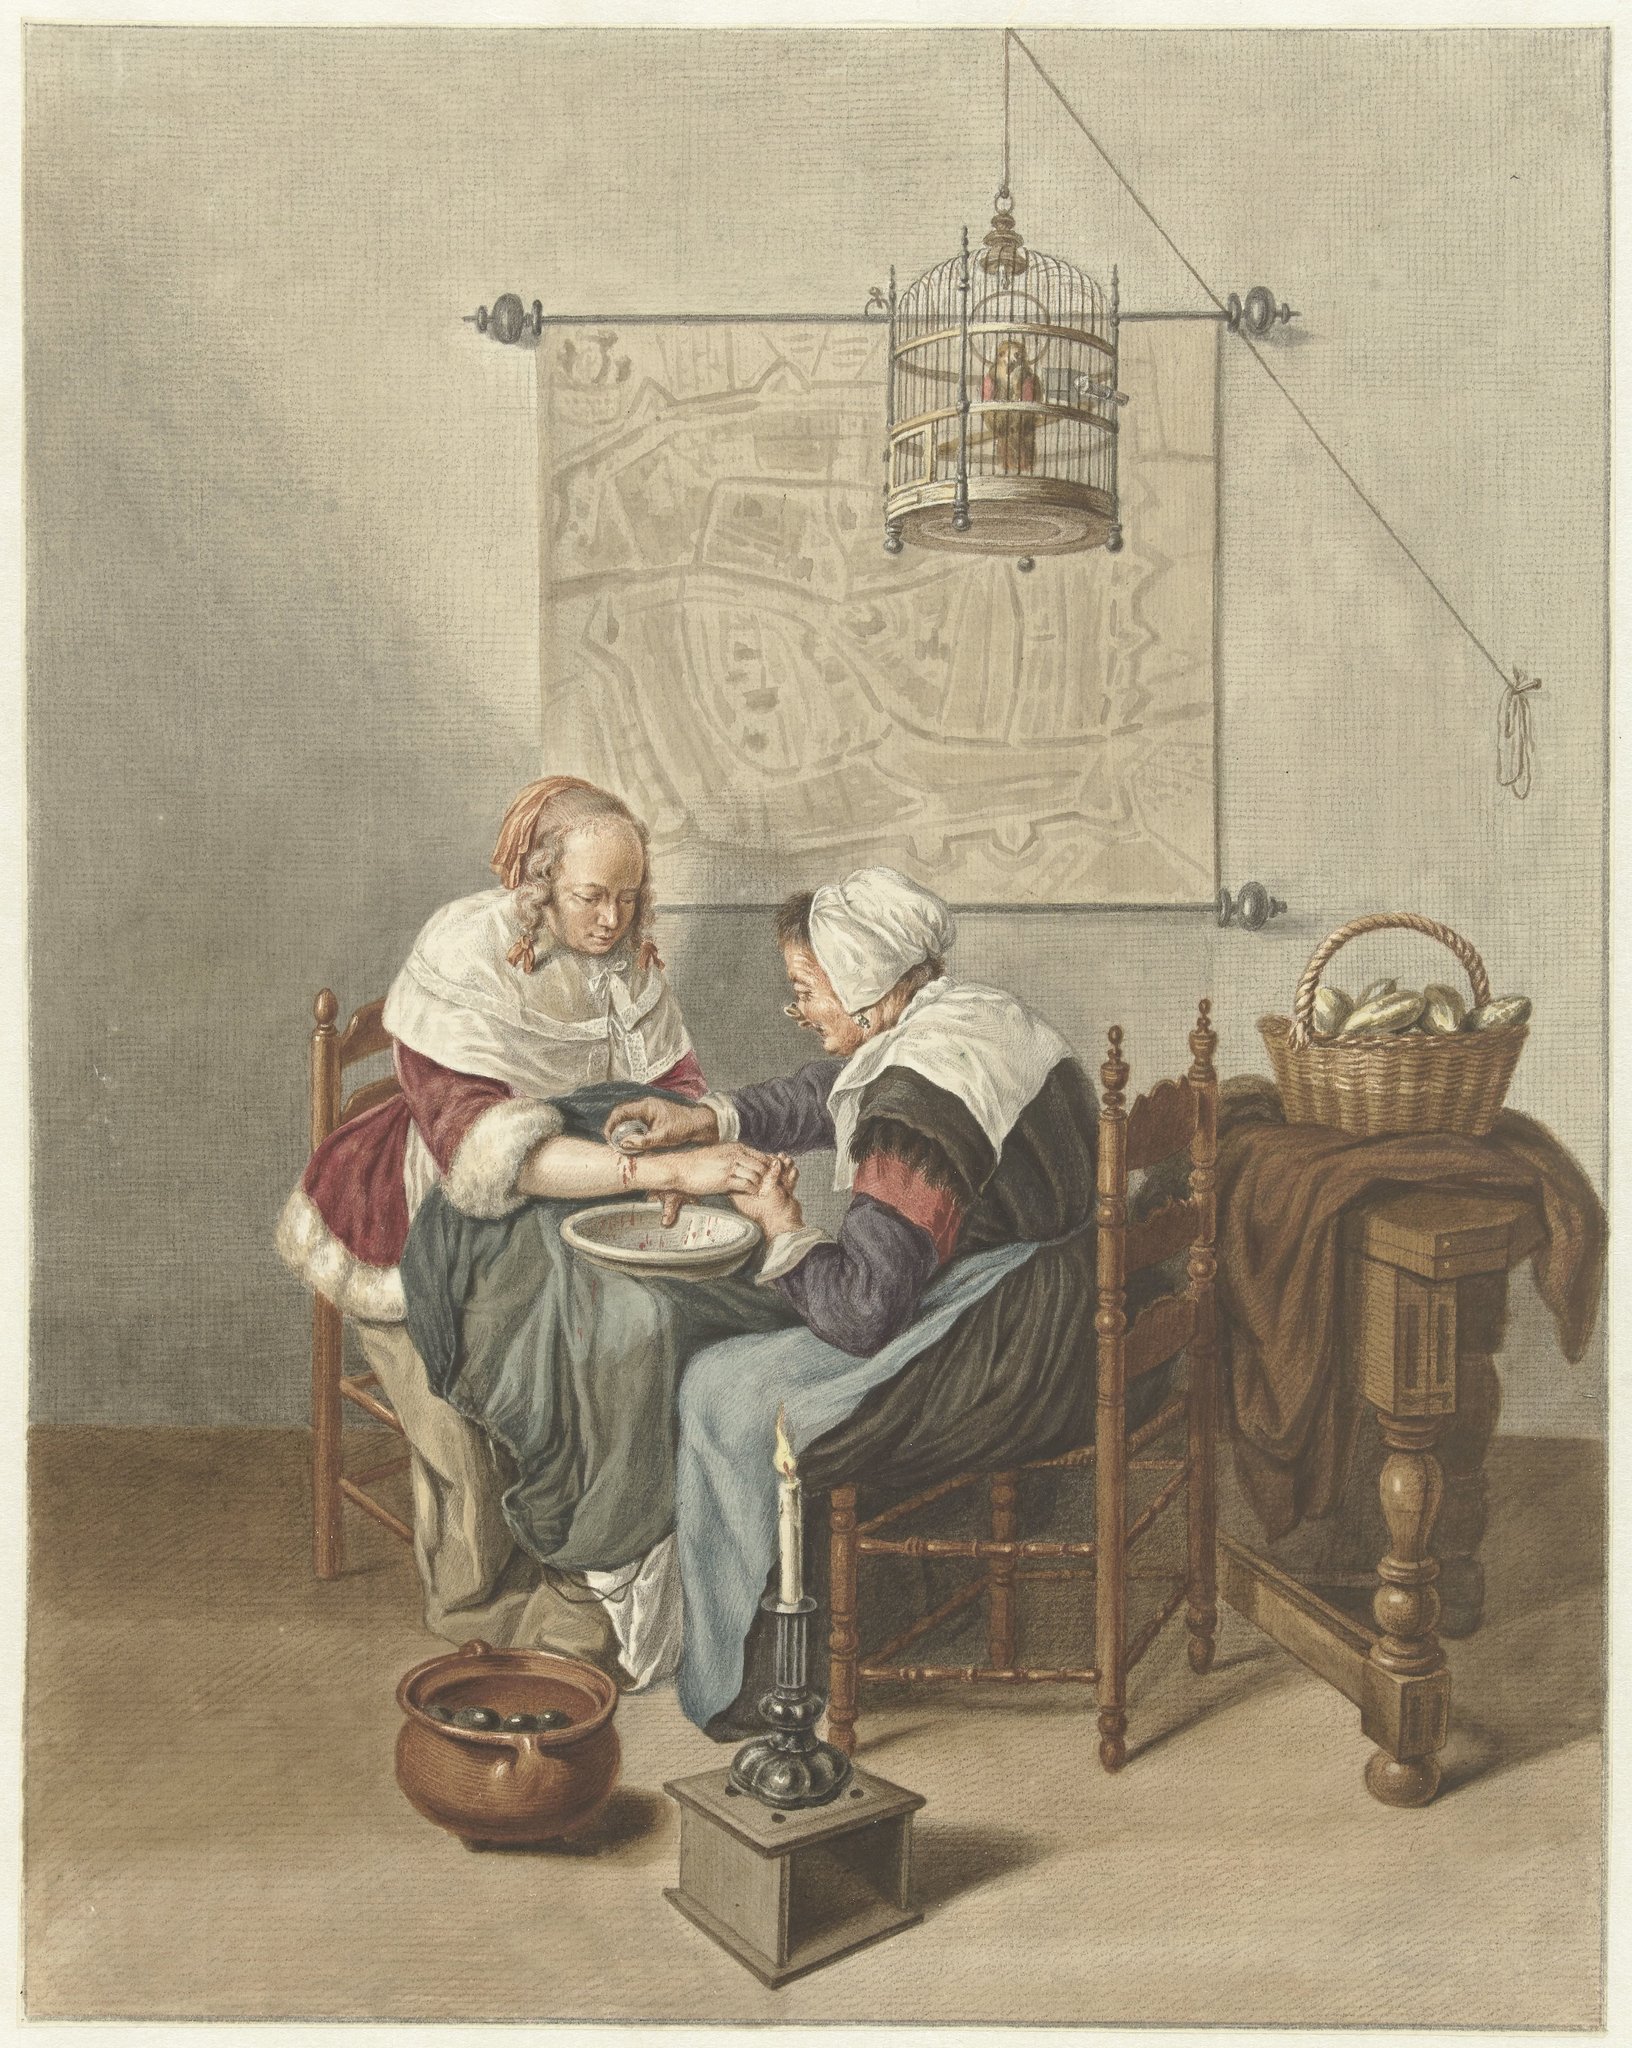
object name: drawing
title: De aderlating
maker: abraham delfos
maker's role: draughtsman, painter, print maker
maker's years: 1731-1820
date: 1776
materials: chalk, ink, paper, watercolor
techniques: brush, pen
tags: bleeding, blood-letting, e.g.: with the aid of cupping-glasses